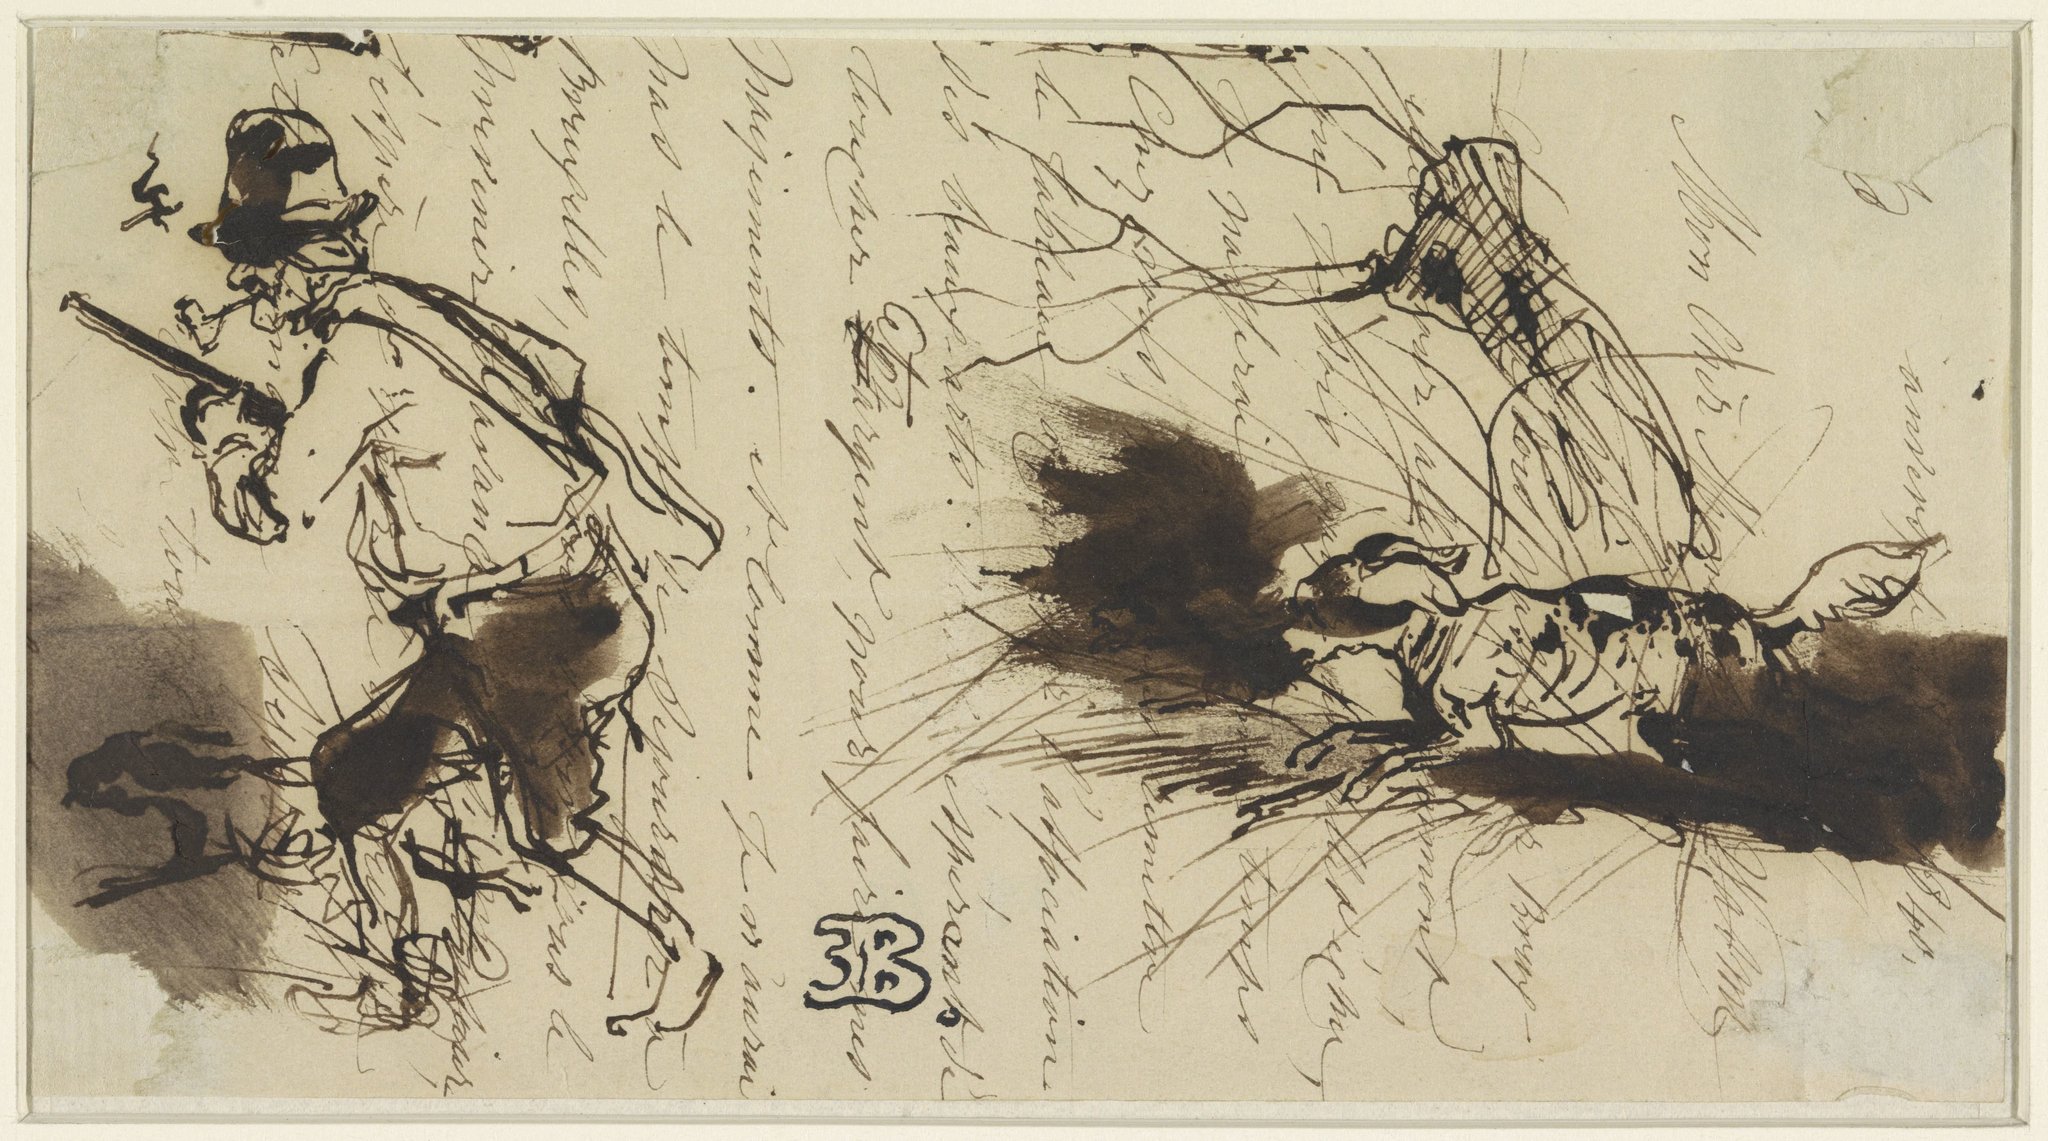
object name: letter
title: Jager met hond, over een brief getekend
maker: eugène françois de block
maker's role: draughtsman, painter, print maker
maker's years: 1812-1893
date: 1840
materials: ink, paper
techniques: brush, pen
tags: hunting dogs, hunters hunting (n.b.: in 1988-1990 this notation denoted the concept of 43c11421 'hunters resting during the hunt')